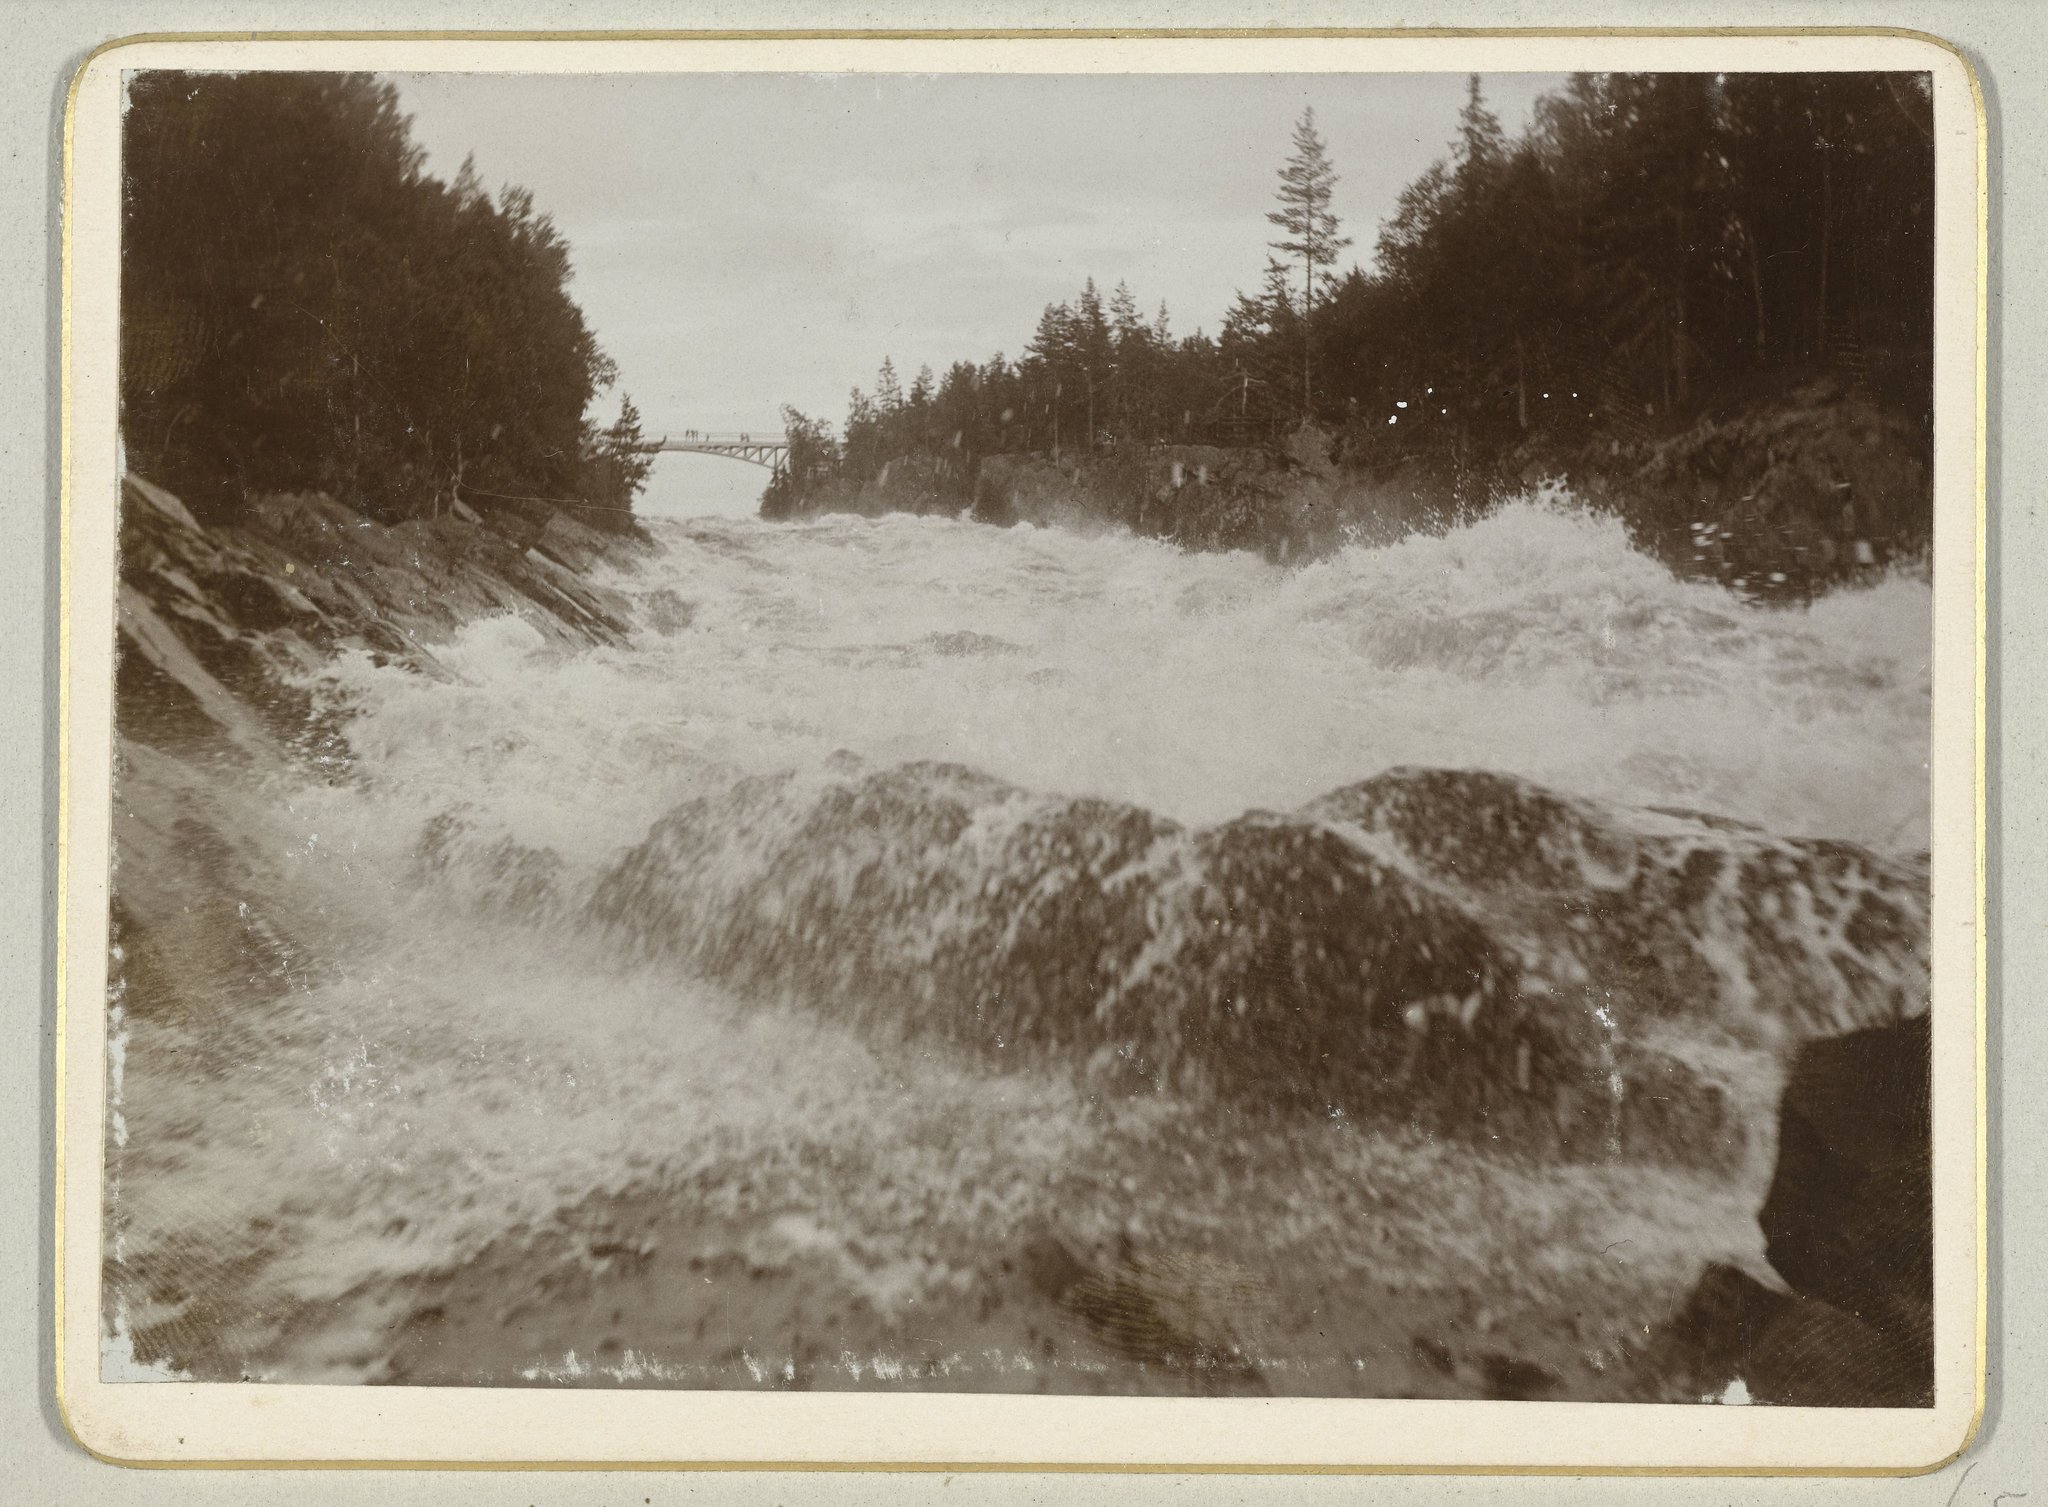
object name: photograph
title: Finland Imatra waterval.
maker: henry pauw van wieldrecht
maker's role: fotograaf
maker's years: 1863-1912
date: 1897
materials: paper, photographic support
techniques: albumen print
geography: helsinki